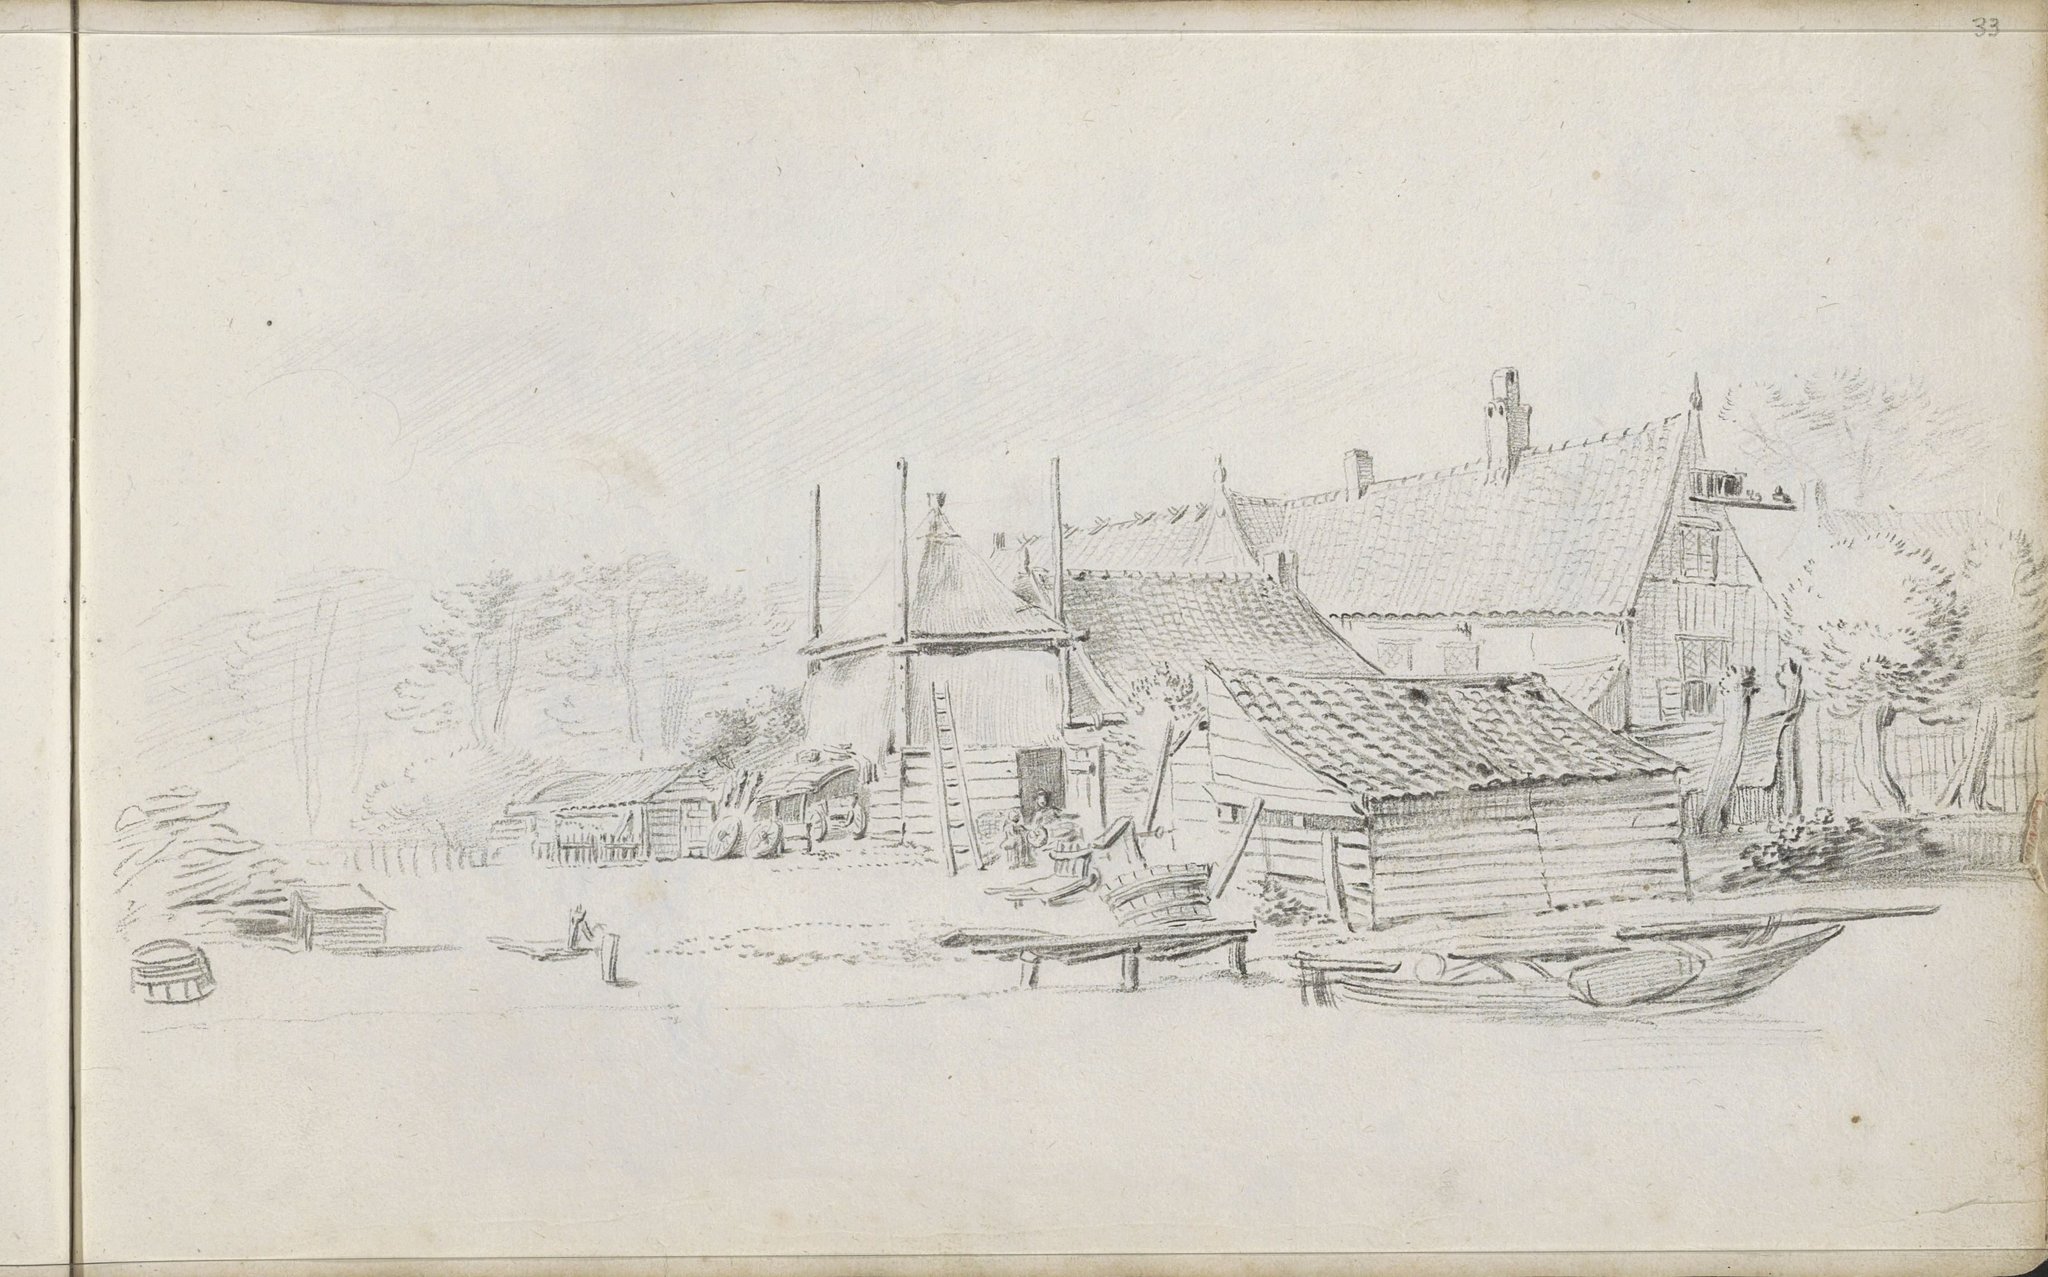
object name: sketchbook leaf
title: Boerderij en erf aan een waterkant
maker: pieter moninckx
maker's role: draughtsman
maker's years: 1606-1686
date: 1645-1646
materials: chalk, paper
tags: water course, farm or solitary house in landscape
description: Landschap met een boerderij en erf waarop landbouwwerktuigen staan zoals een kar en kruiwagen. Op de voorgrond een aanlegsteiger. Blad 33 recto uit een schetsboek met 39 bladen.